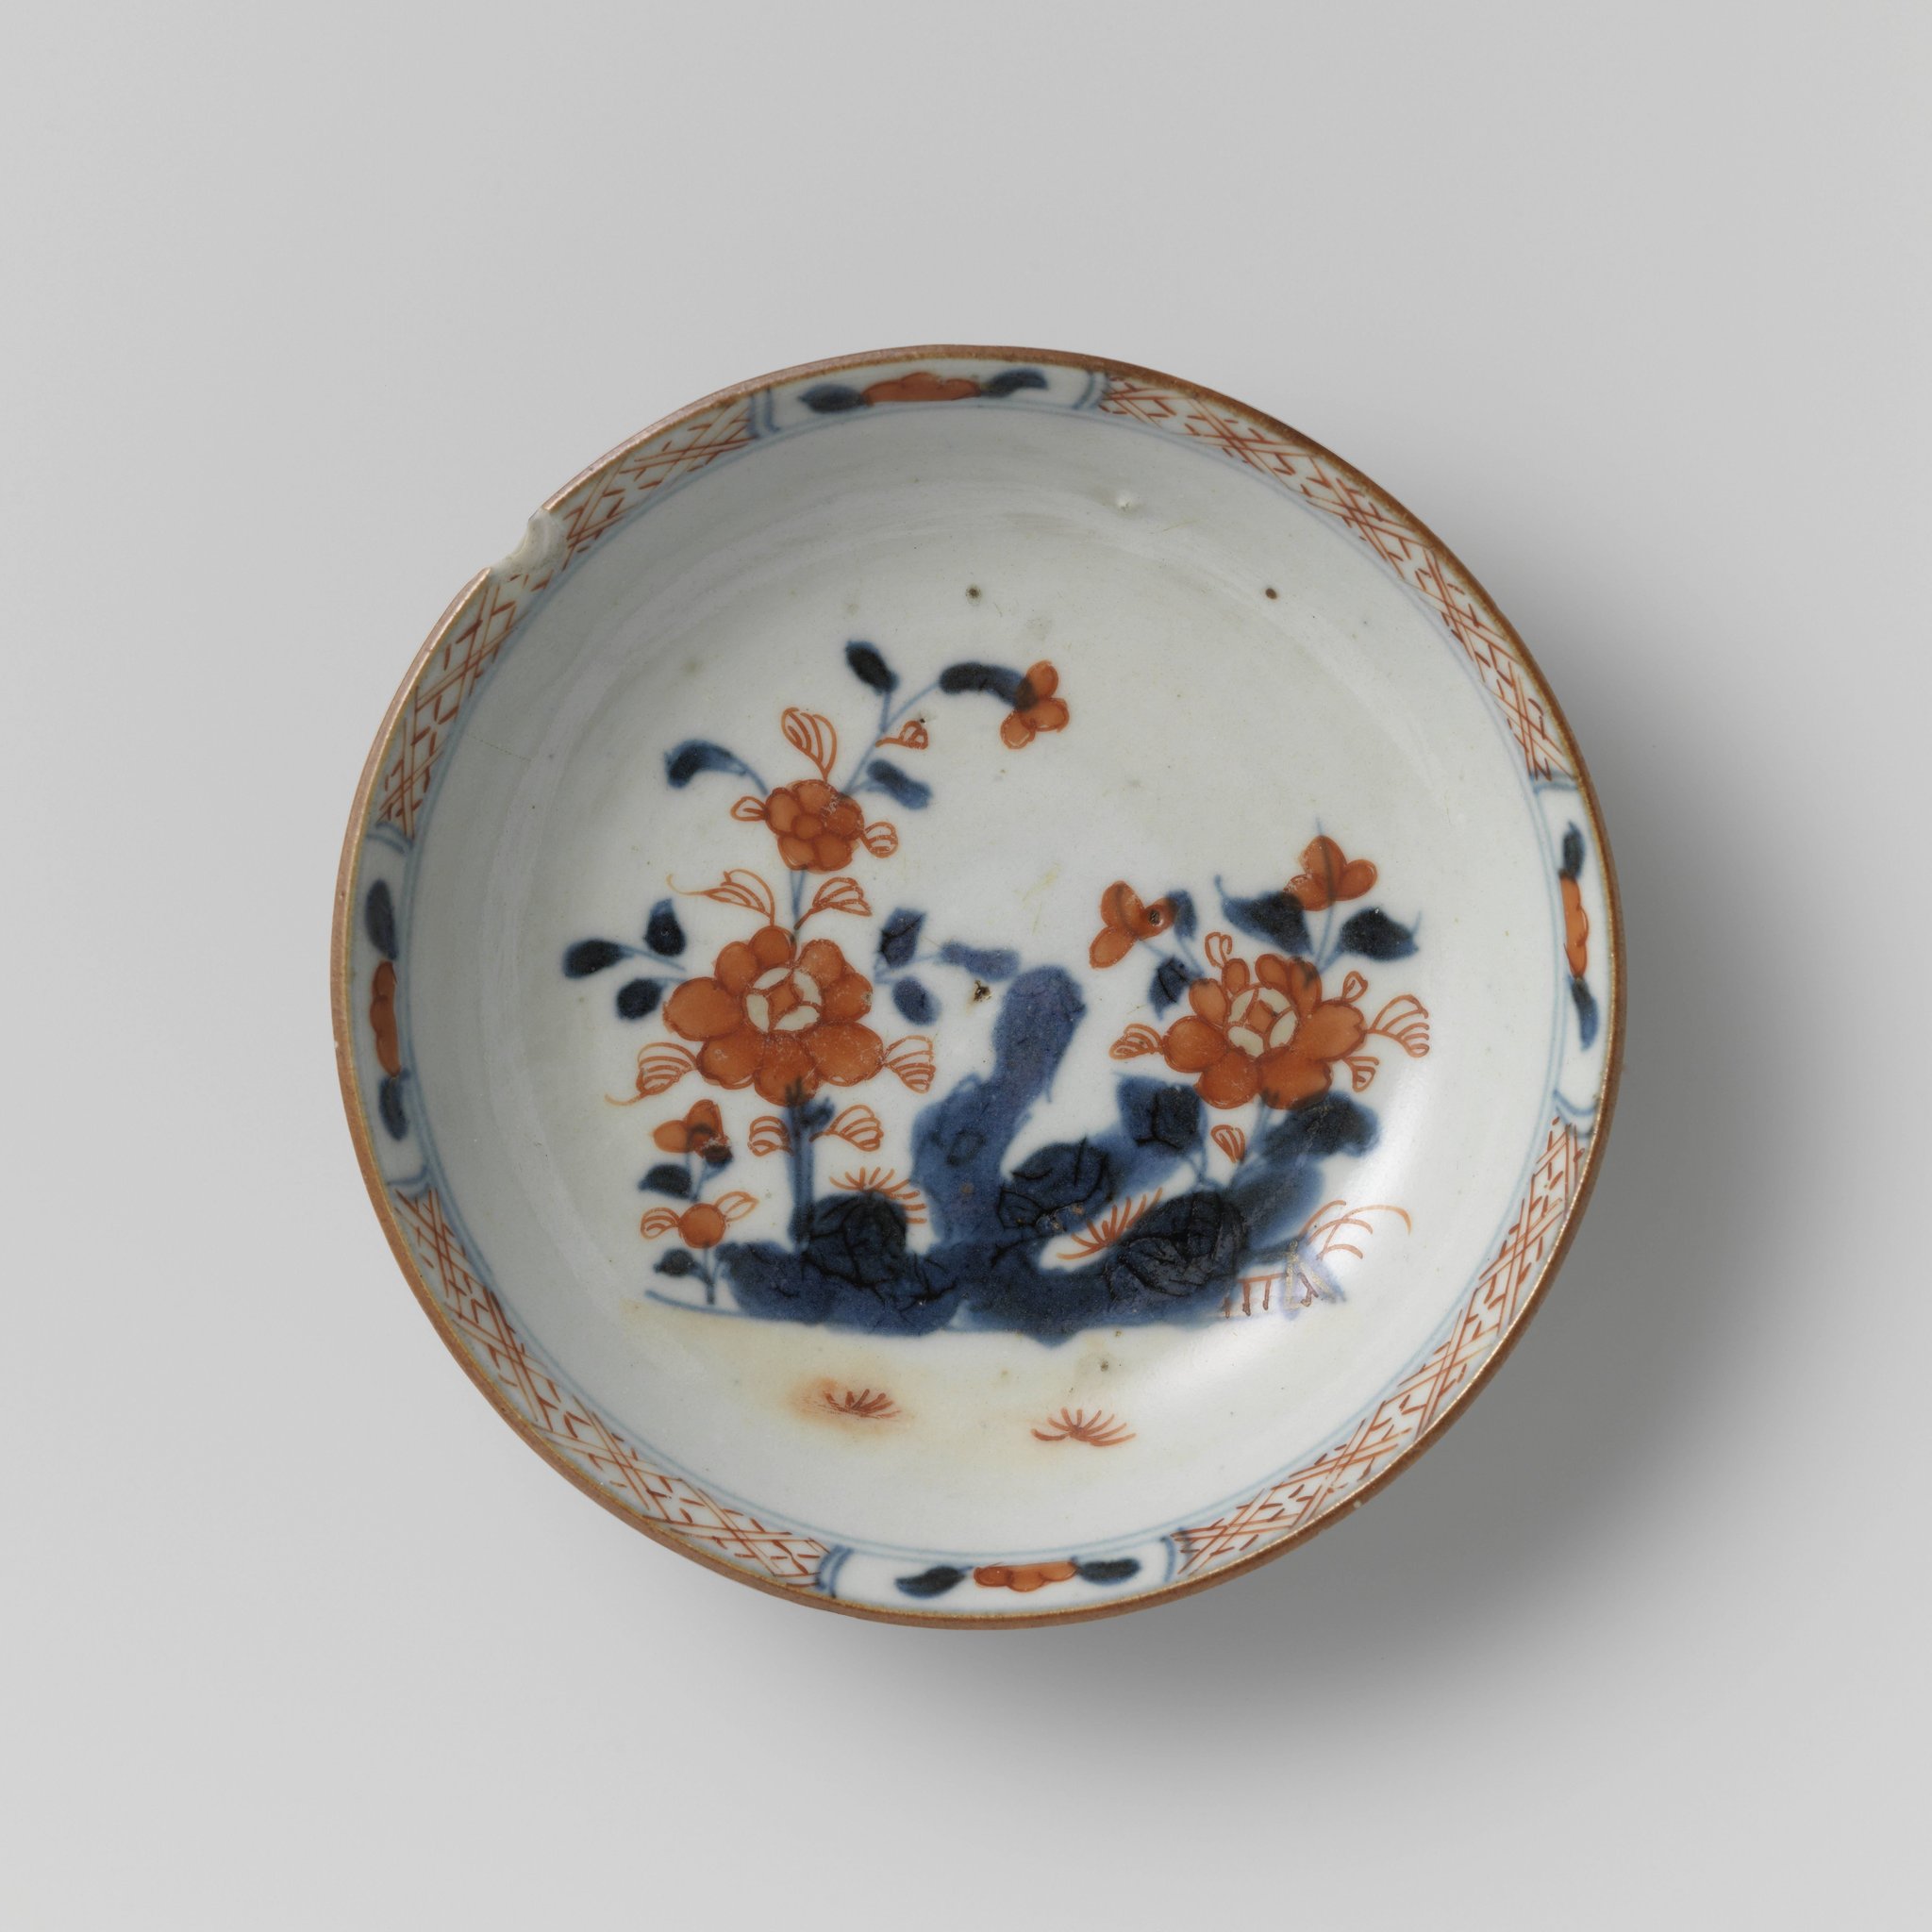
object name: platter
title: Saucer with flowering plants near a rock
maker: Anonymous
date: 1730-1770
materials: cobalt, glaze, gold, paint, porcelain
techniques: firing, gilding, turning, vitrification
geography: china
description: Kop en schotel, capucijnergoed, aan de binnenzijde planten in blauw en rood.